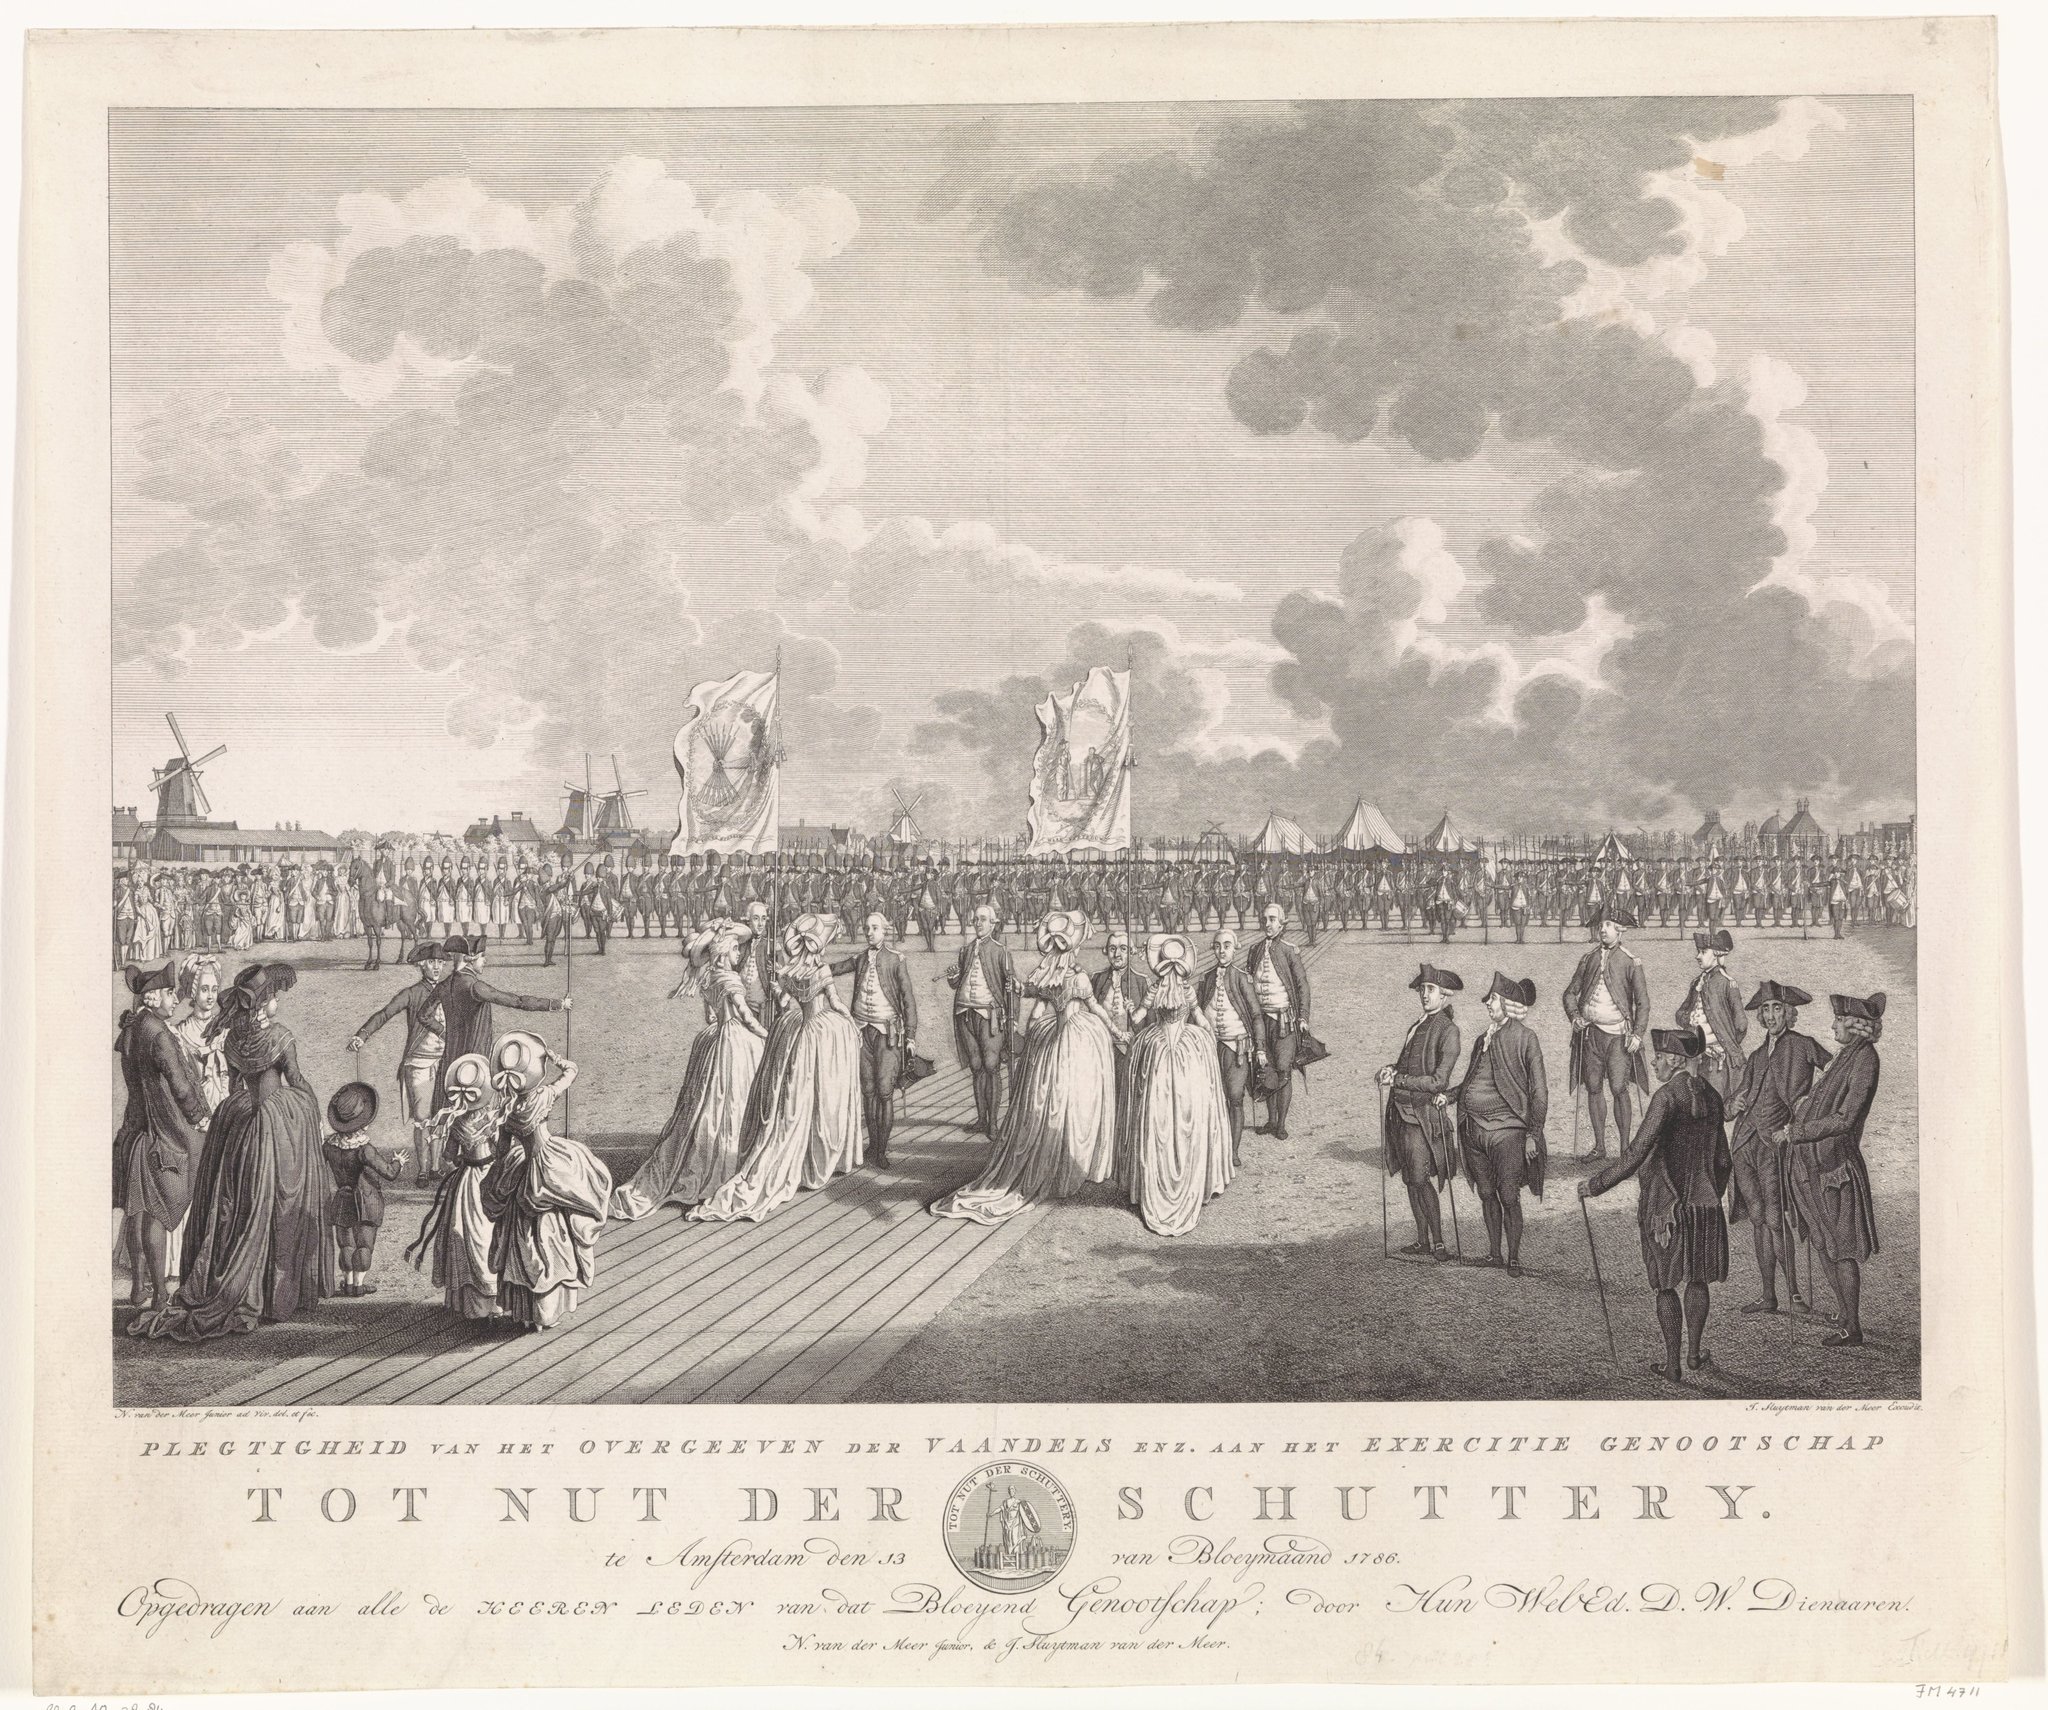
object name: print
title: Plegtigheid van het overgeeven der vaandels enz. aan het execitie genootschap tot nut der schuttery (...)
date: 1786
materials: paper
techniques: engraving, etching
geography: amsterdam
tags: windmill, guard duty, keeping sentry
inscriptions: collector's mark: Lugt 2228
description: Het excercitieterrein van de schutterij in Amsterdam, bij de Stadhouderskade ter hoogte van de latere P.C. Hooftstraat. Twee vaandels worden overgegeven aan het Excercitiegenootschap Tot Nut der Schutterij, 1786.